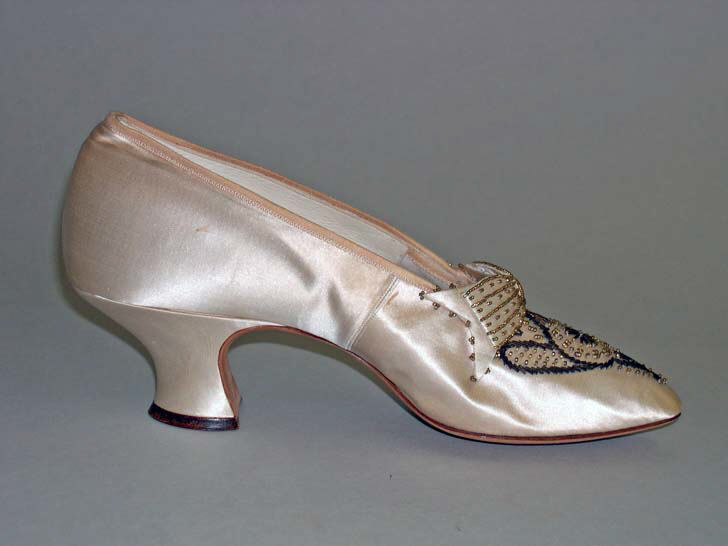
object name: shoe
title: Shoes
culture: american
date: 1890-1900